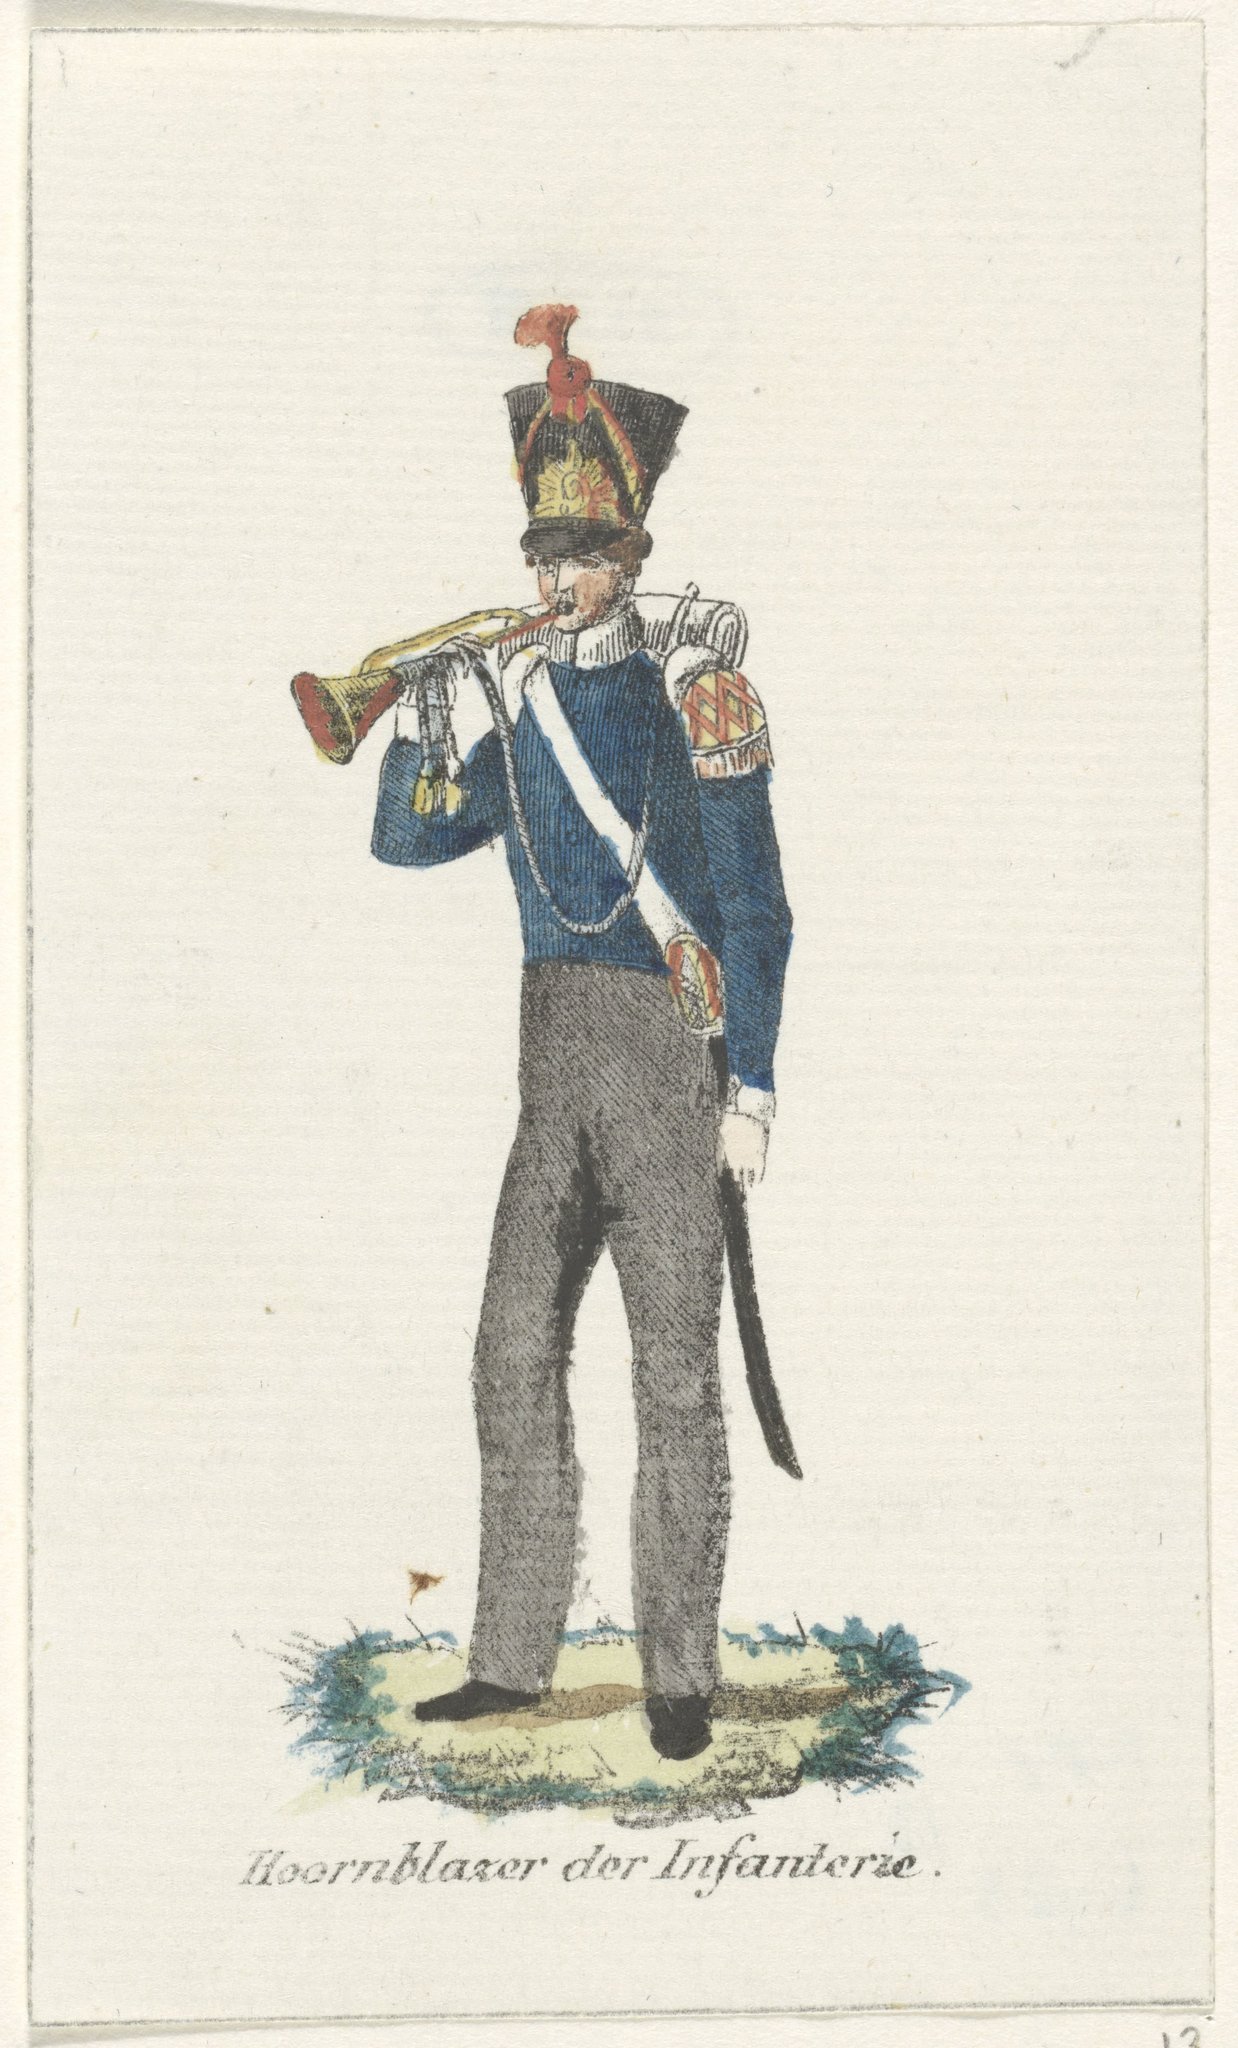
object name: costume print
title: Hoornblazer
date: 1830-1835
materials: paper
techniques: hand coloring, lithograph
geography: netherlands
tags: (military) uniforms, clothes, costume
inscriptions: collector's mark: Lugt 2228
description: Verkleinde kopieën naar de prenten van Houtman e.a. in FMH 6481. Muller beschrijft een onversneden compleet blad in de collectie Van Gijn waarop de namen van de prentmaker en de uitgever vermeld staan.